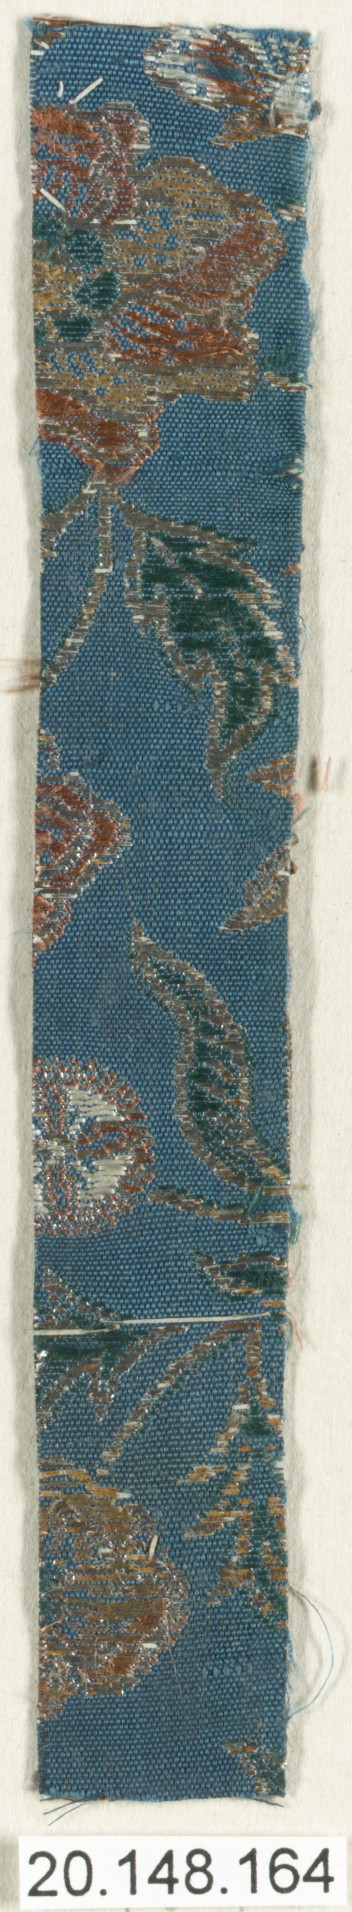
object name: piece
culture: japanese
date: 1601-1700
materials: silk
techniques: compound weave